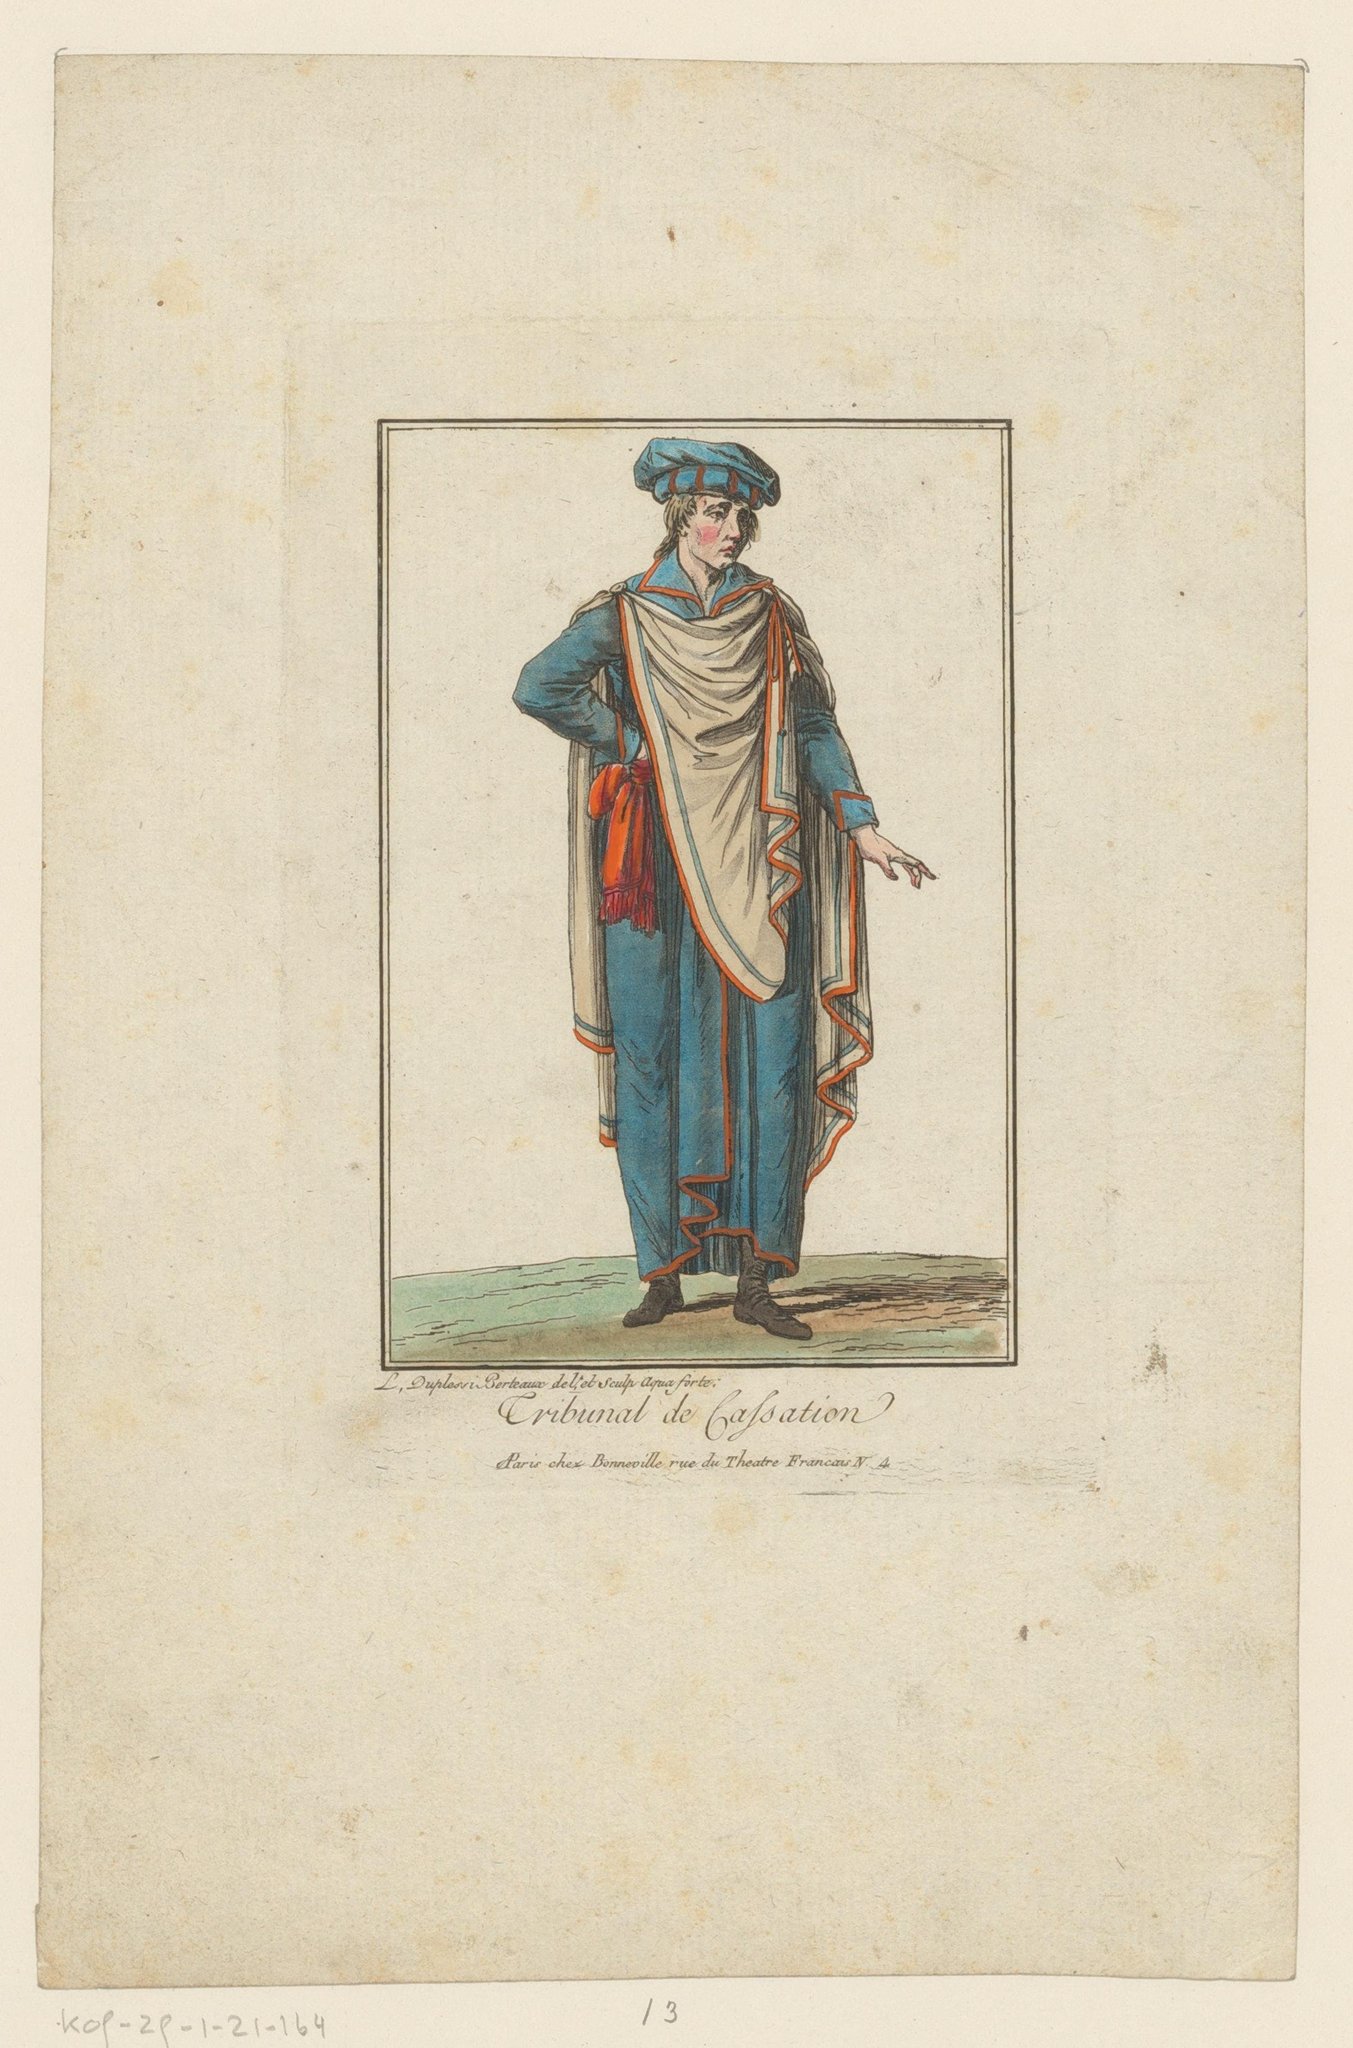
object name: print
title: Kostuums van de leden van twee raden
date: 1795-1799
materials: paper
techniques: etching, hand coloring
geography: paris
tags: standing figure, national government, clothes, costume, head-gear: hat (+ feathers used for clothes)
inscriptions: collector's mark: Lugt 1641, stamp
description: Onderwerpsrubrieken binnen de Atlas Zeden en Gewoonten: Zeden en Gewoonten in Engeren Zin, De Kleeding, Kleederdrachten (tijdvakken), De Fransche Revolutie. (Het Directoire).